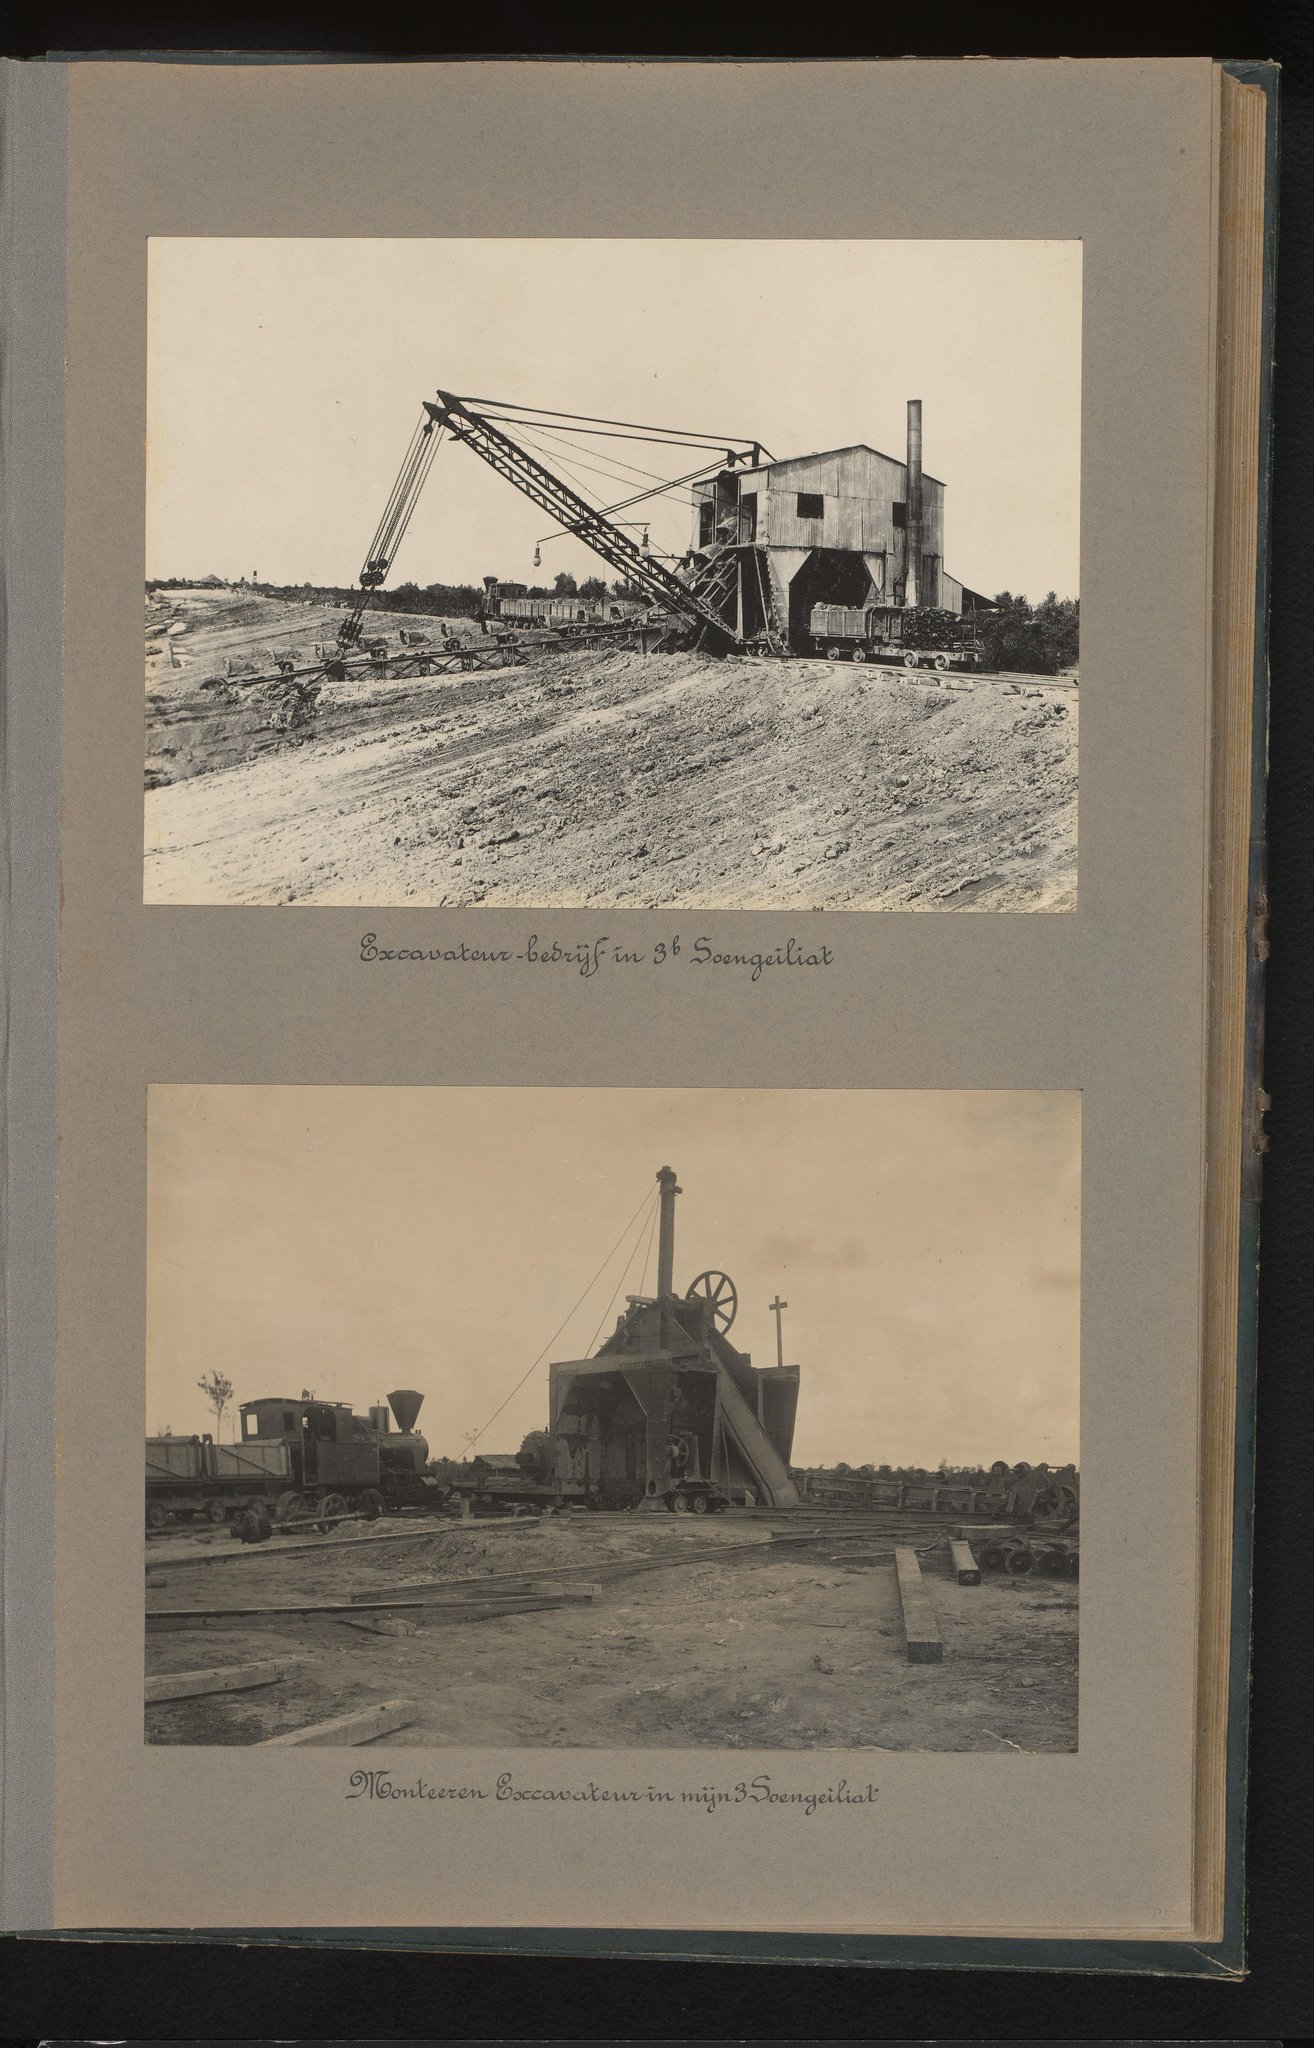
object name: photograph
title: Excavateur van de Banka-tinwinning te Soengeiliat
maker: Anonymous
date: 1914-1919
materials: cardboard, photographic support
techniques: gelatin silver print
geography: bangka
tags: robert julius boers, colonial system, opencast mine; strip mining, machines; parts of machines; tools and appliances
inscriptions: inscription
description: Albumblad met 2 foto's van een excavateur van de Banka-tinwinning te Soengeiliat. Onderdeel van het fotoalbum aangeboden aan Robert Julius Boers bij zijn vertrek naar Nederland in 1919 door het personeel van de Banka-tinwinning.